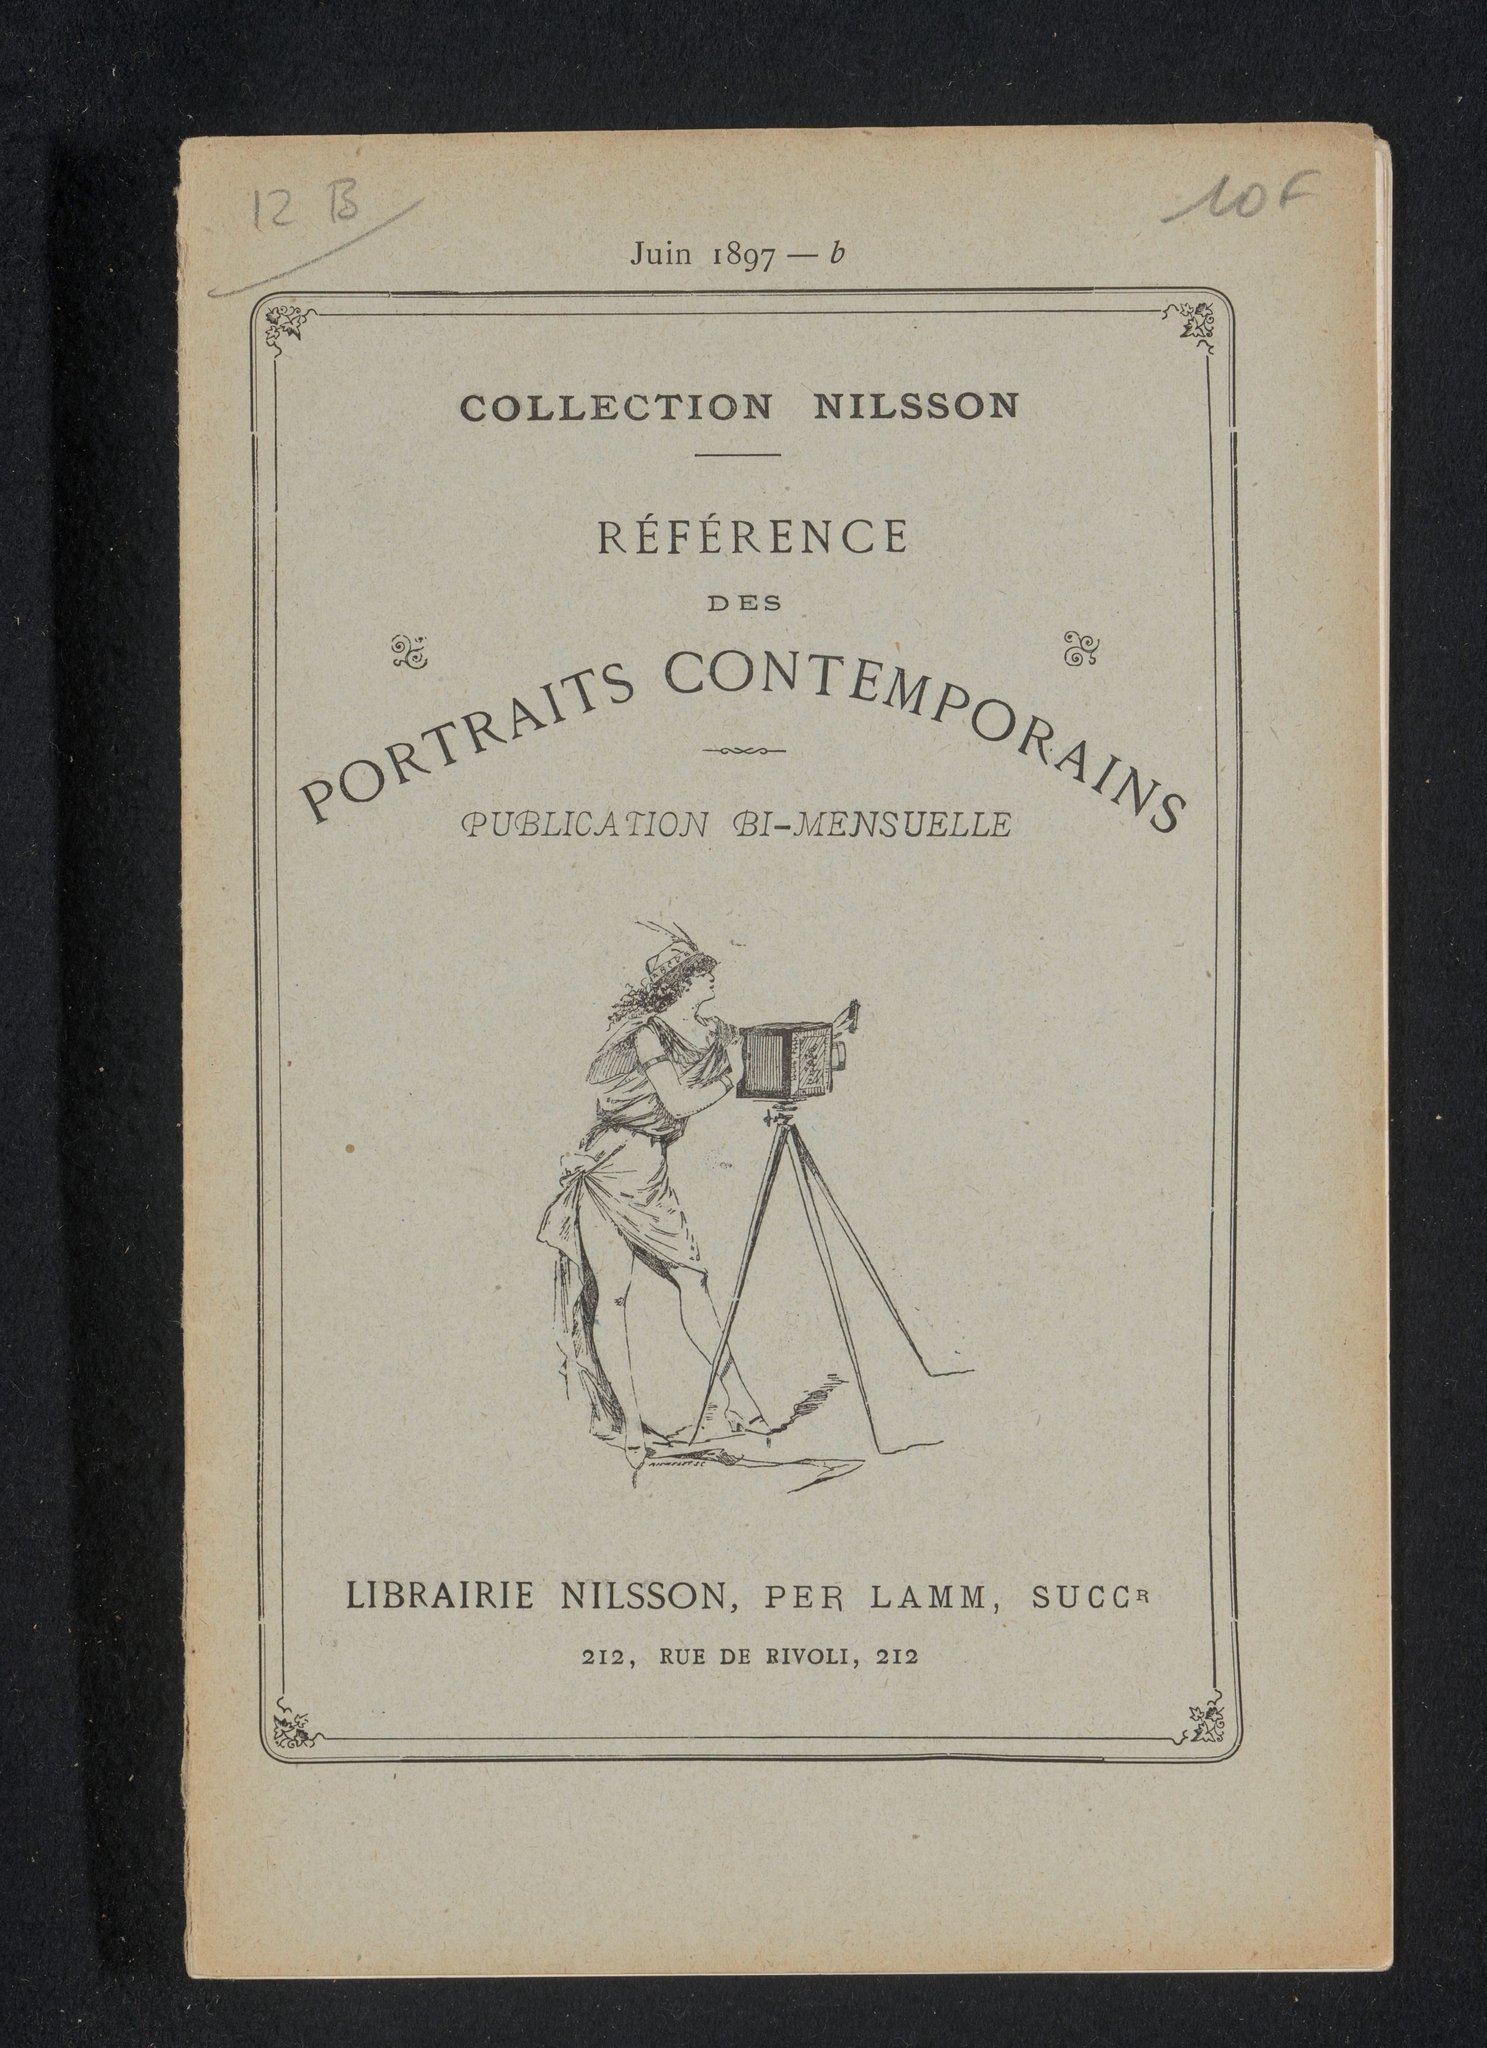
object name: magazine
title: Référence des portraits contemporains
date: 1806-1897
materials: paper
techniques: photograph, printing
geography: paris